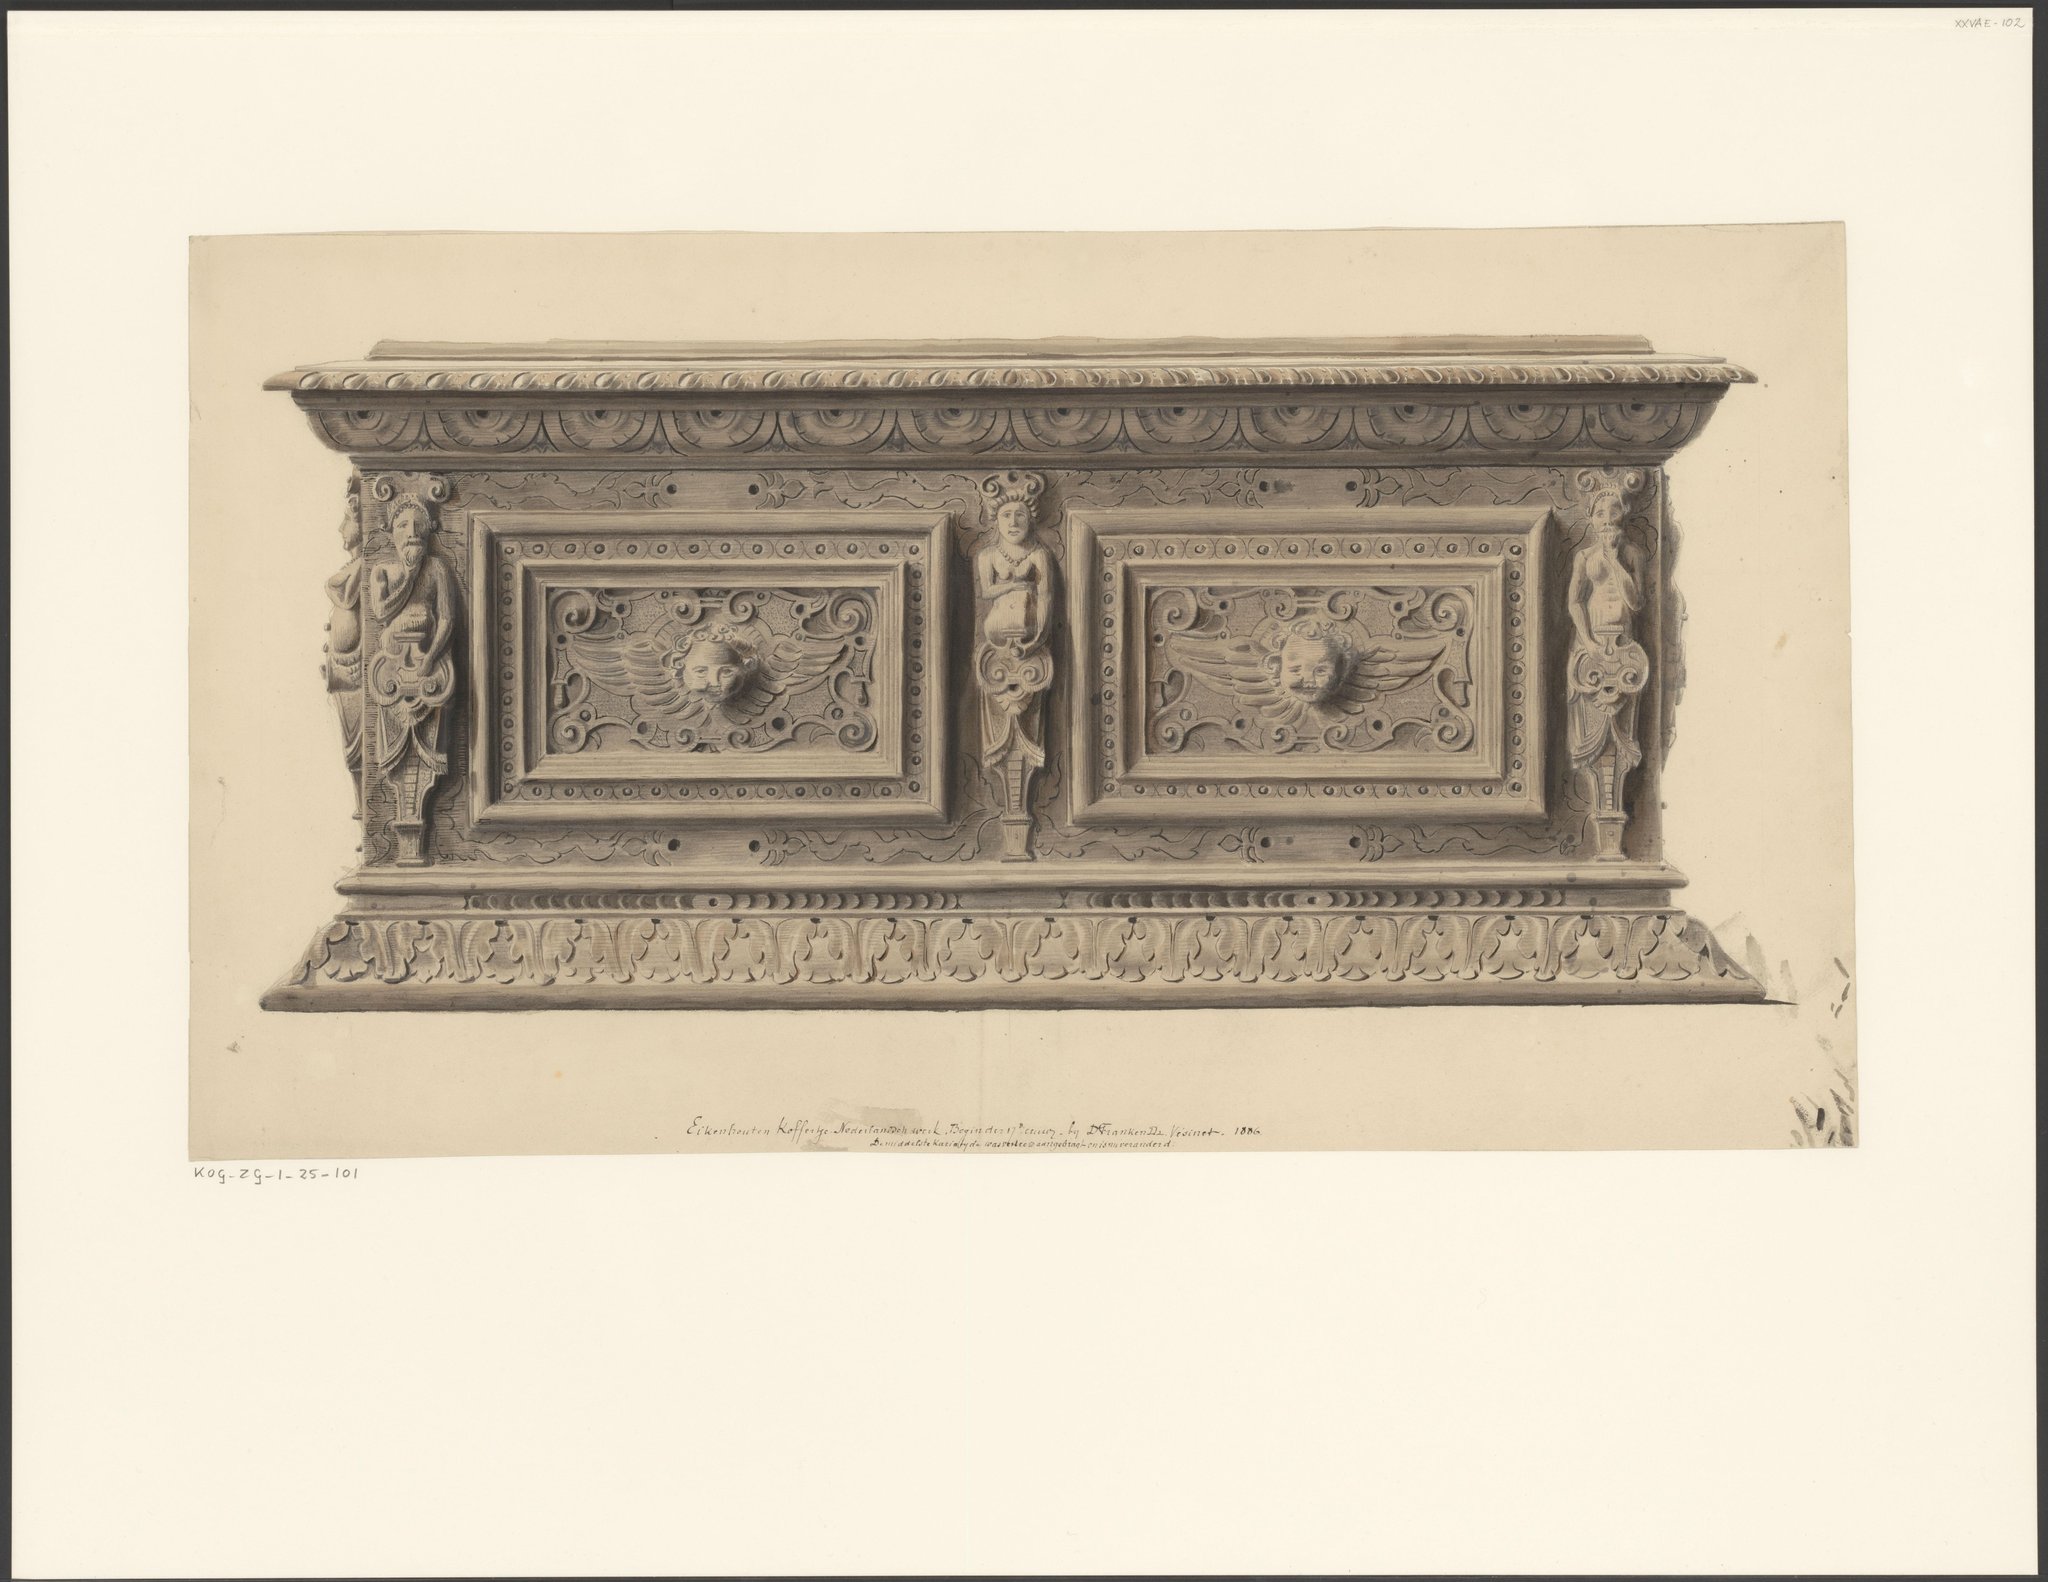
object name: drawing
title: Eikenhouten Koffertje Nederlandsch werk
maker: Anonymous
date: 1886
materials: ink, paper, pencil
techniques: brush, pen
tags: chest, coffer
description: Uit de collectie van Daniel Franken Dz. Onderwerpsrubrieken binnen de Atlas Zeden en Gewoonten: Zeden en Gewoonten in Engeren Zin, De Woning, Binnenhuizen, Meubelen.